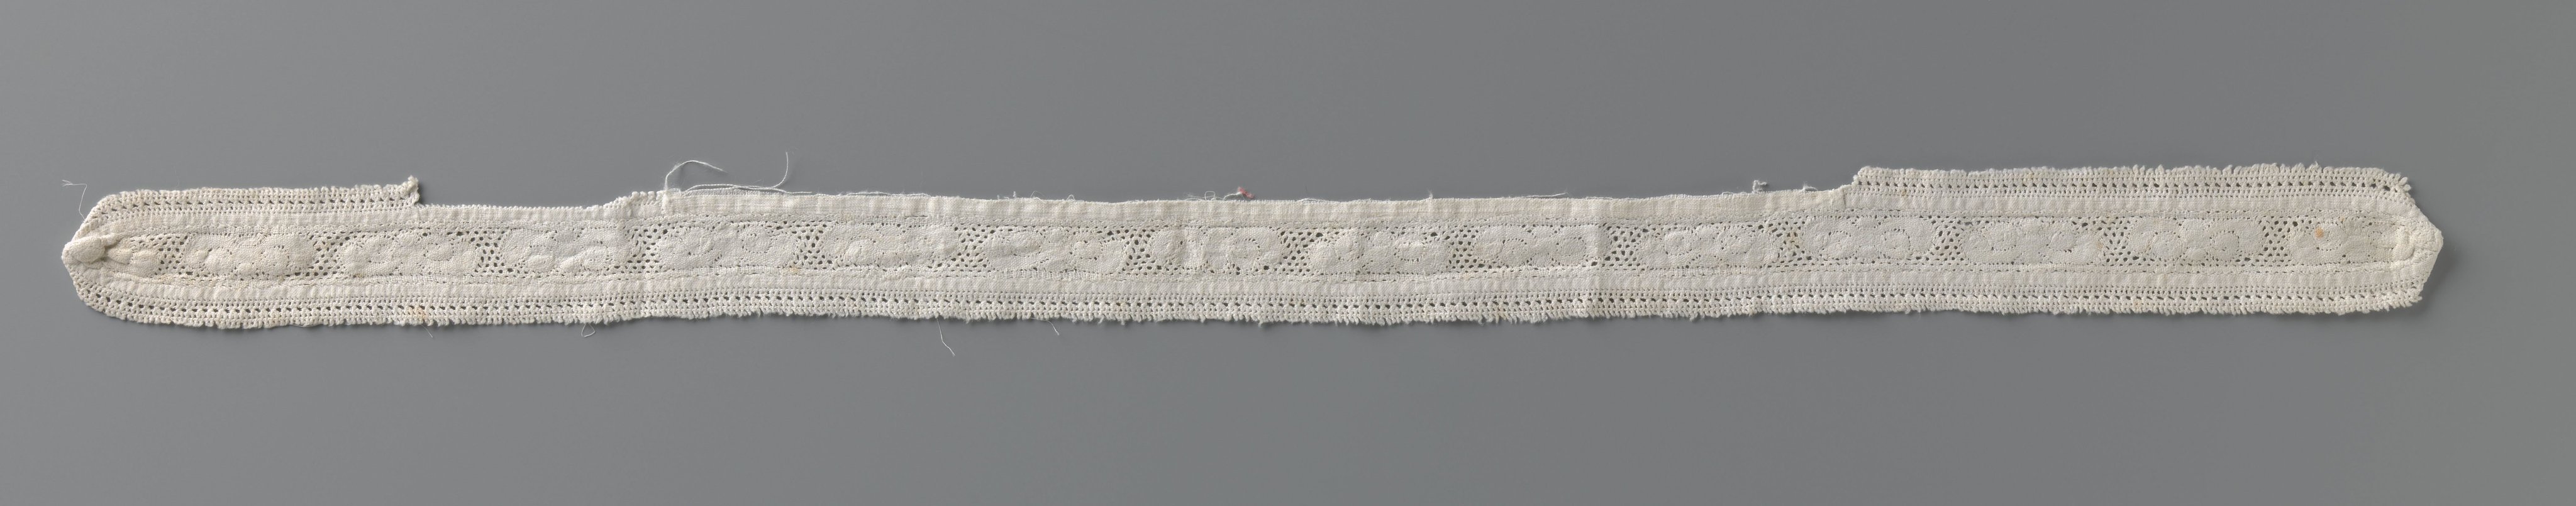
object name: entre deux, tussenzetsel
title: Tussenzetsel van kloskant met voluutmotief aan overblijfselen van linnen beddengoed met werk met uitgetrokken draden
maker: Anonymous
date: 1640-1660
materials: linen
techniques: lace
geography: southern netherlands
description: Tussenzetsel van naturelkleurige Hollandse kloskant. Het zich herhalende en symmetrische patroon bestaat uit een voluutmotief dat afwisselend omgekeerd is geplaatst. De motieven zijn gemaakt in linnenslag met opengewerkte randjes en zijn met elkaar verbonden door een traliegrond. Boven- en onderzijde van de strook zijn recht afgewerkt en elk bevestigd aan een smalle strook linnen - zomen - met daaraan een smalle rand werk met uitgetrokken draden. Aan één lange kant is een deel van het werk met uitgetrokken draden verdwenen en het middengedeelte is een aparte zoom waar geen sporen van werk met uitgetrokken draden aan te zien zijn. Elke korte zijde is tot een puntje aan elkaar genaaid. Het betreft de overblijfselen van beddengoed, waarschijnlijk een kussensloop. Mogelijk is het kant vervaardigd in Vlaanderen en is het beddengoed gemaakt in de Noordelijke Nederlanden.